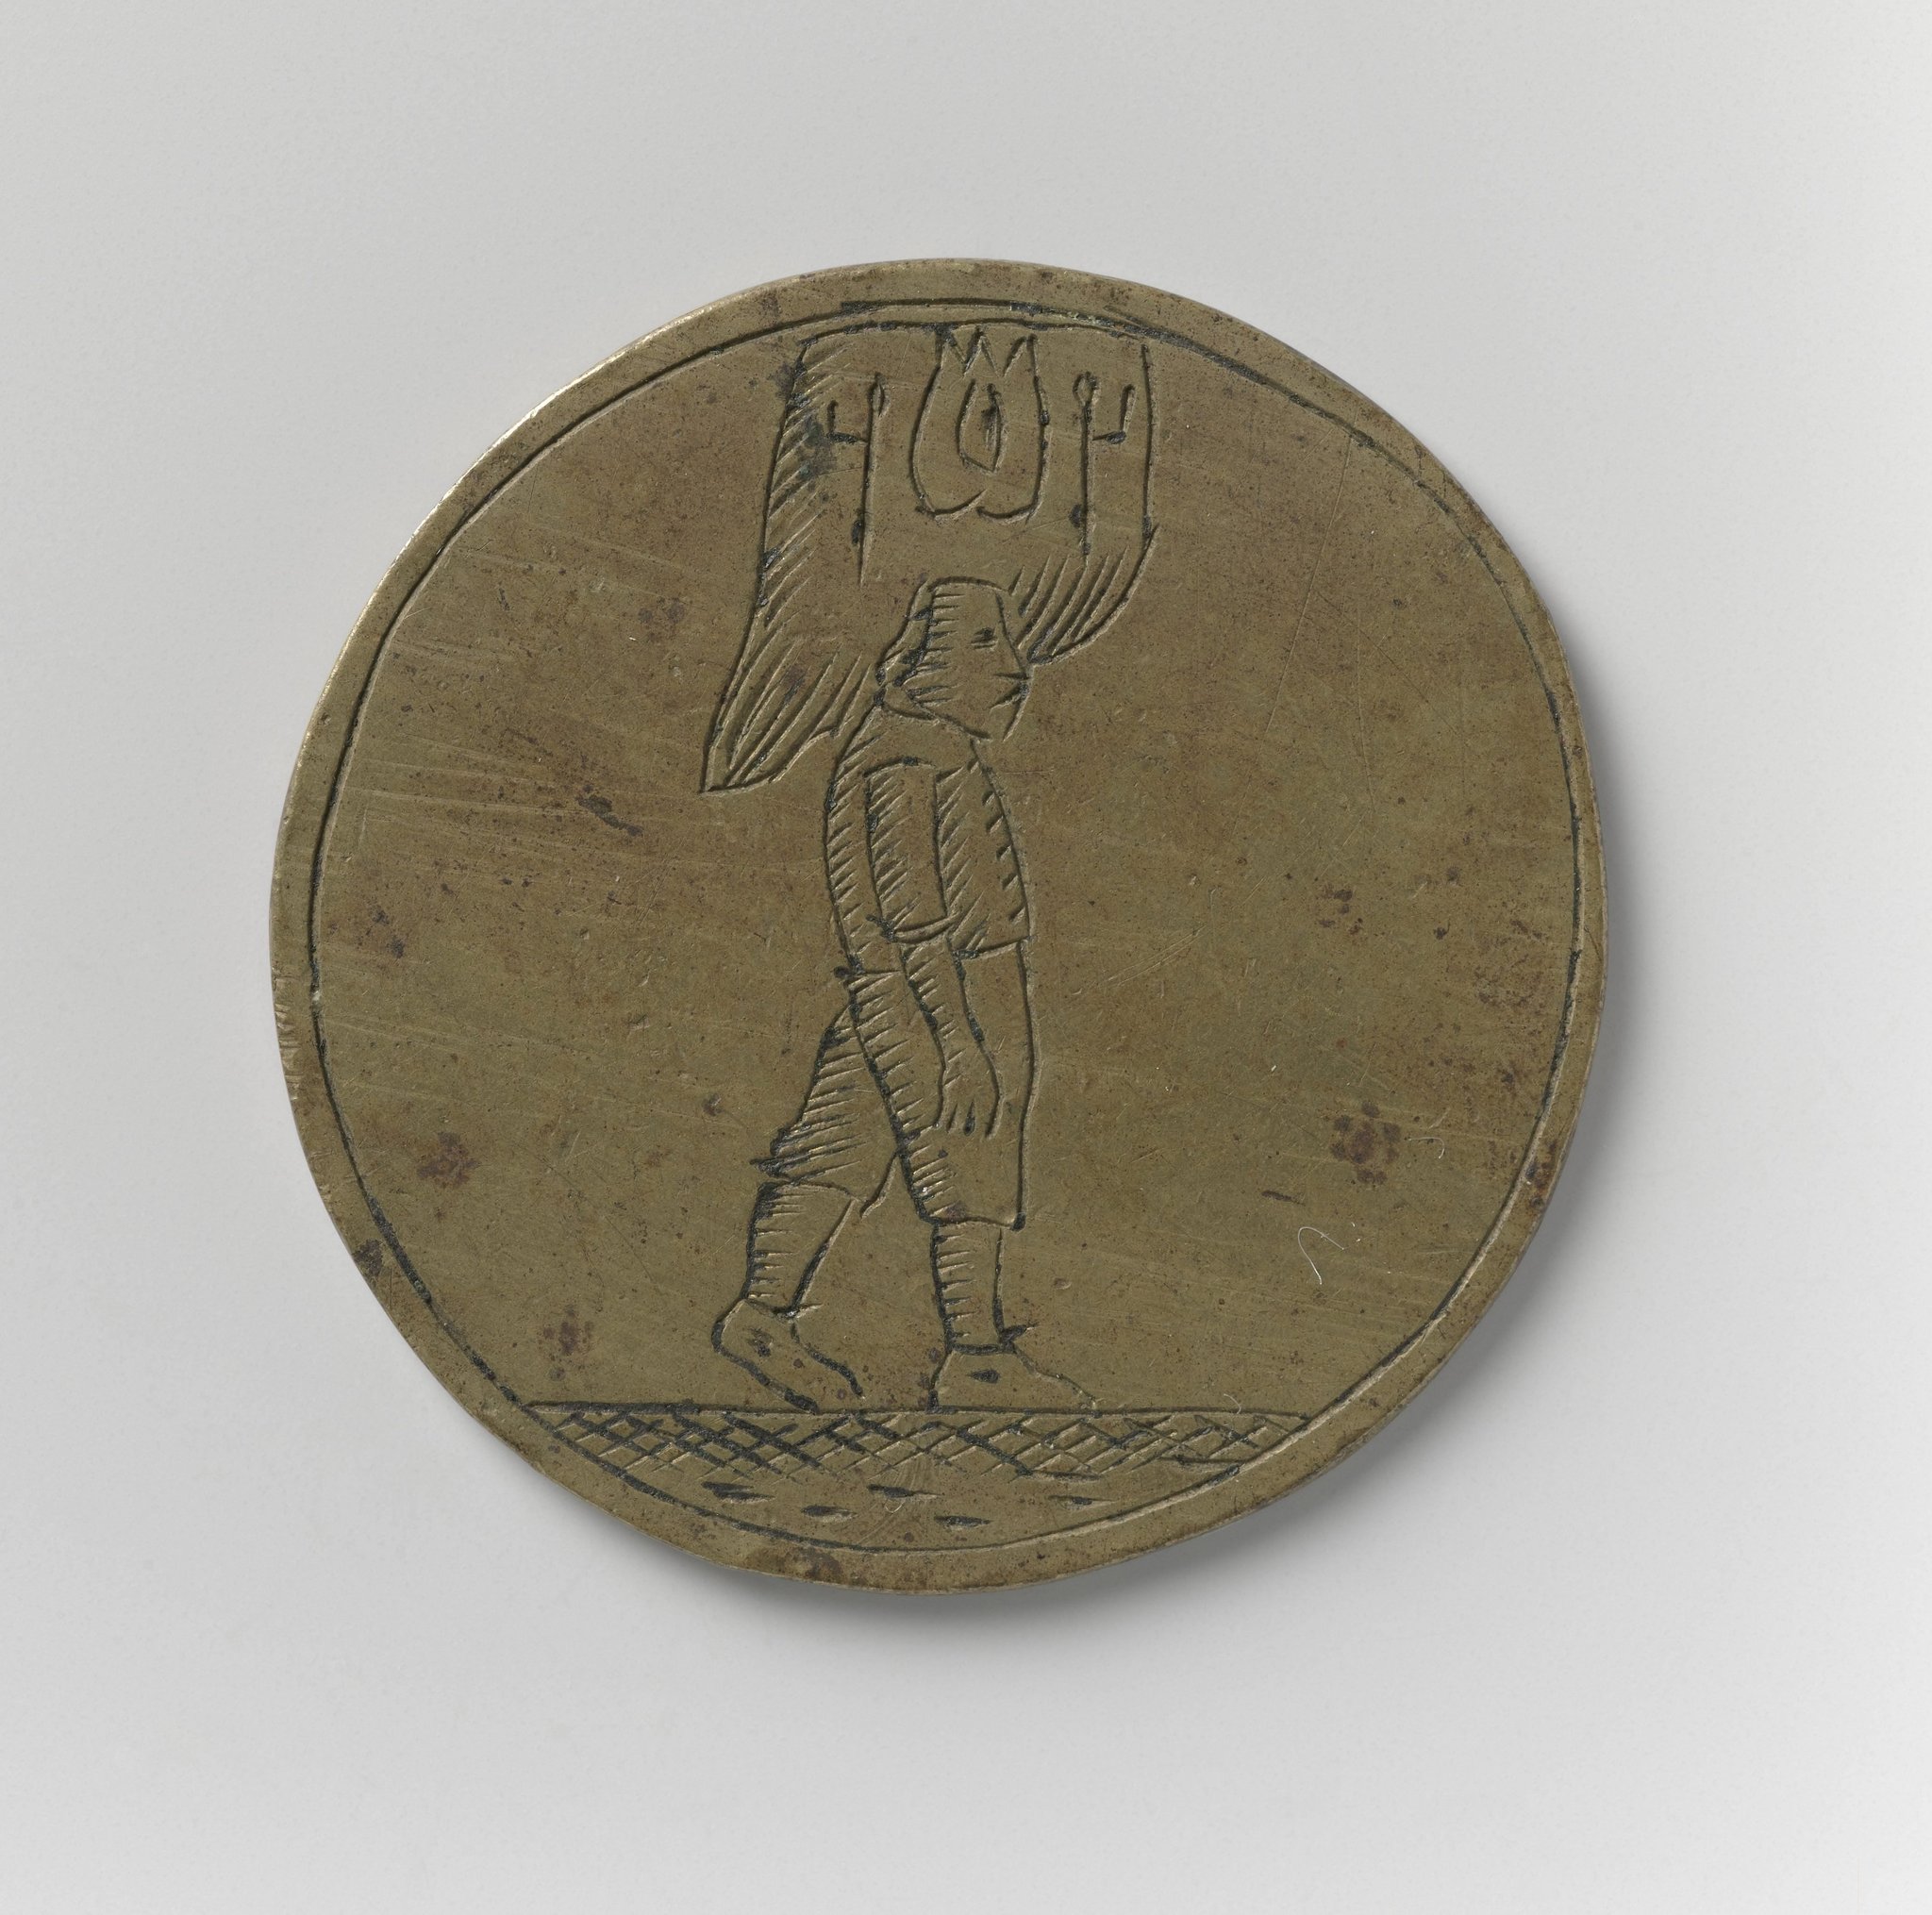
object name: medal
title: Korendragers- en -stortersgilde van Amsterdam, gildepenning van Claes Gerse van den Horn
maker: Anonymous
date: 1693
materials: brass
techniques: engraving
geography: amsterdam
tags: amsterdam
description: Messing penning. Voorzijde: naar rechts gewende man met last op hoofd. Keerzijde: opschrift